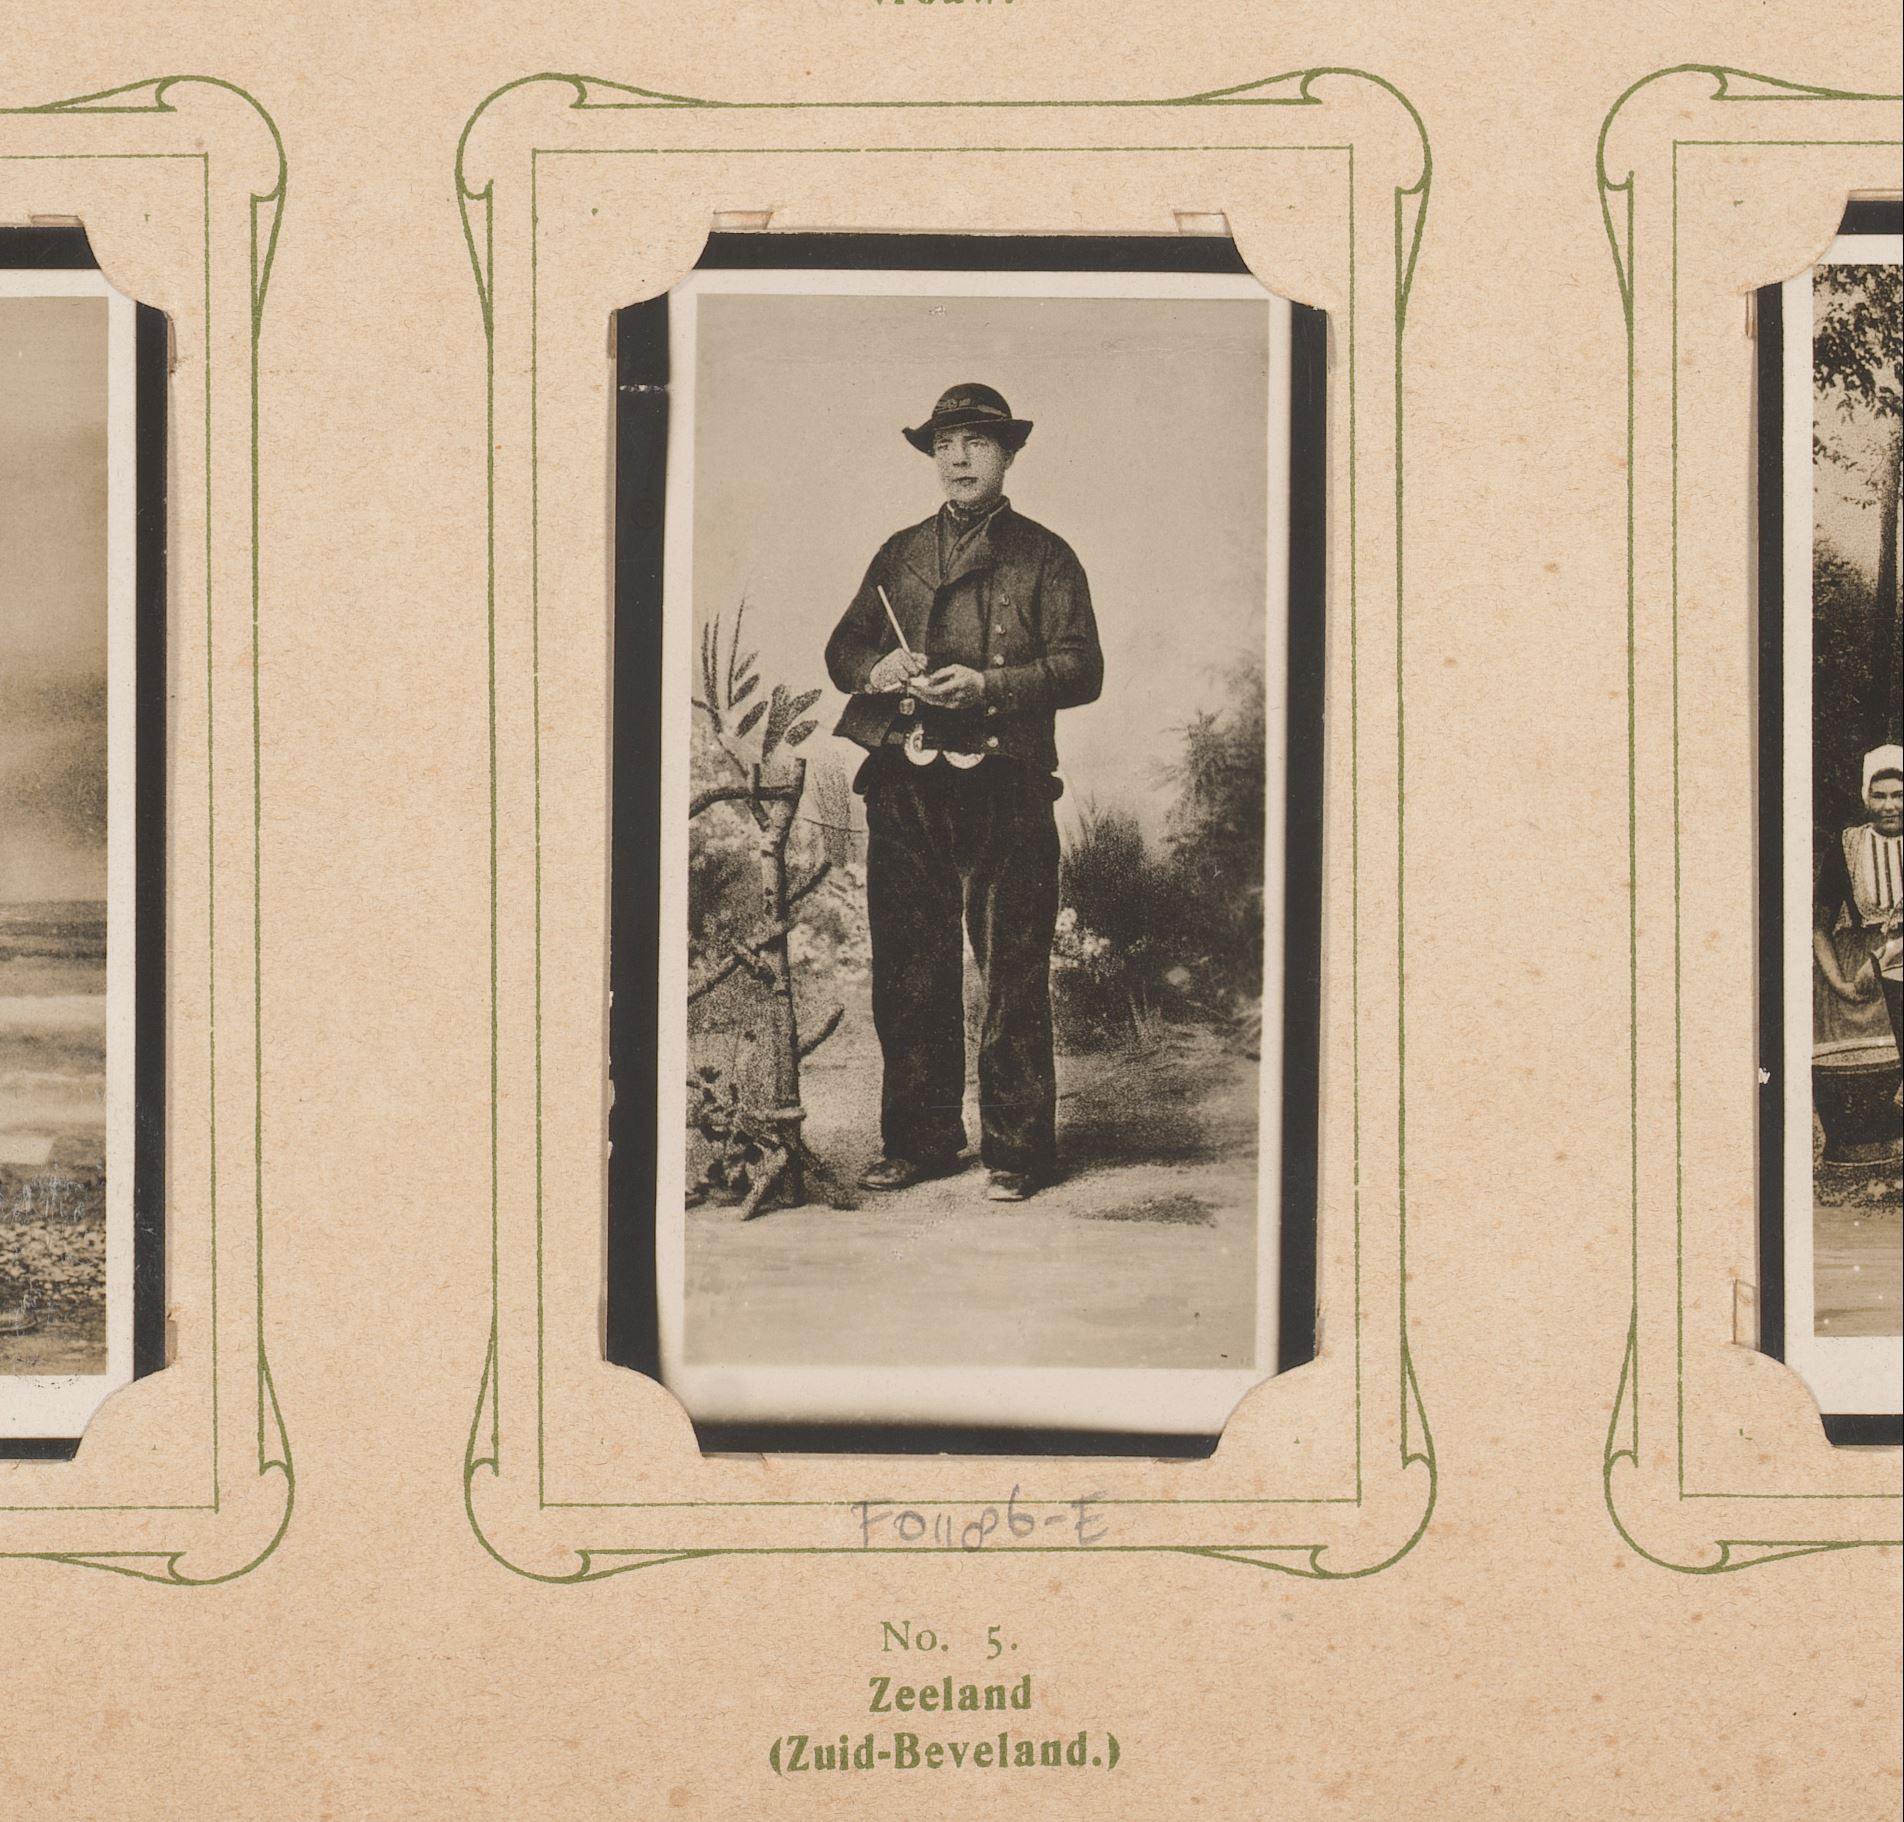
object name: album leaf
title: Portret van een man in Hollandse klederdracht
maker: Anonymous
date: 1904-1905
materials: photographic support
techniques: gelatin silver print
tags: historical persons, folk costume, regional costume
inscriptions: inscription: ‘No. 5./ Zeeland/ (Zuid-Beveland.)’